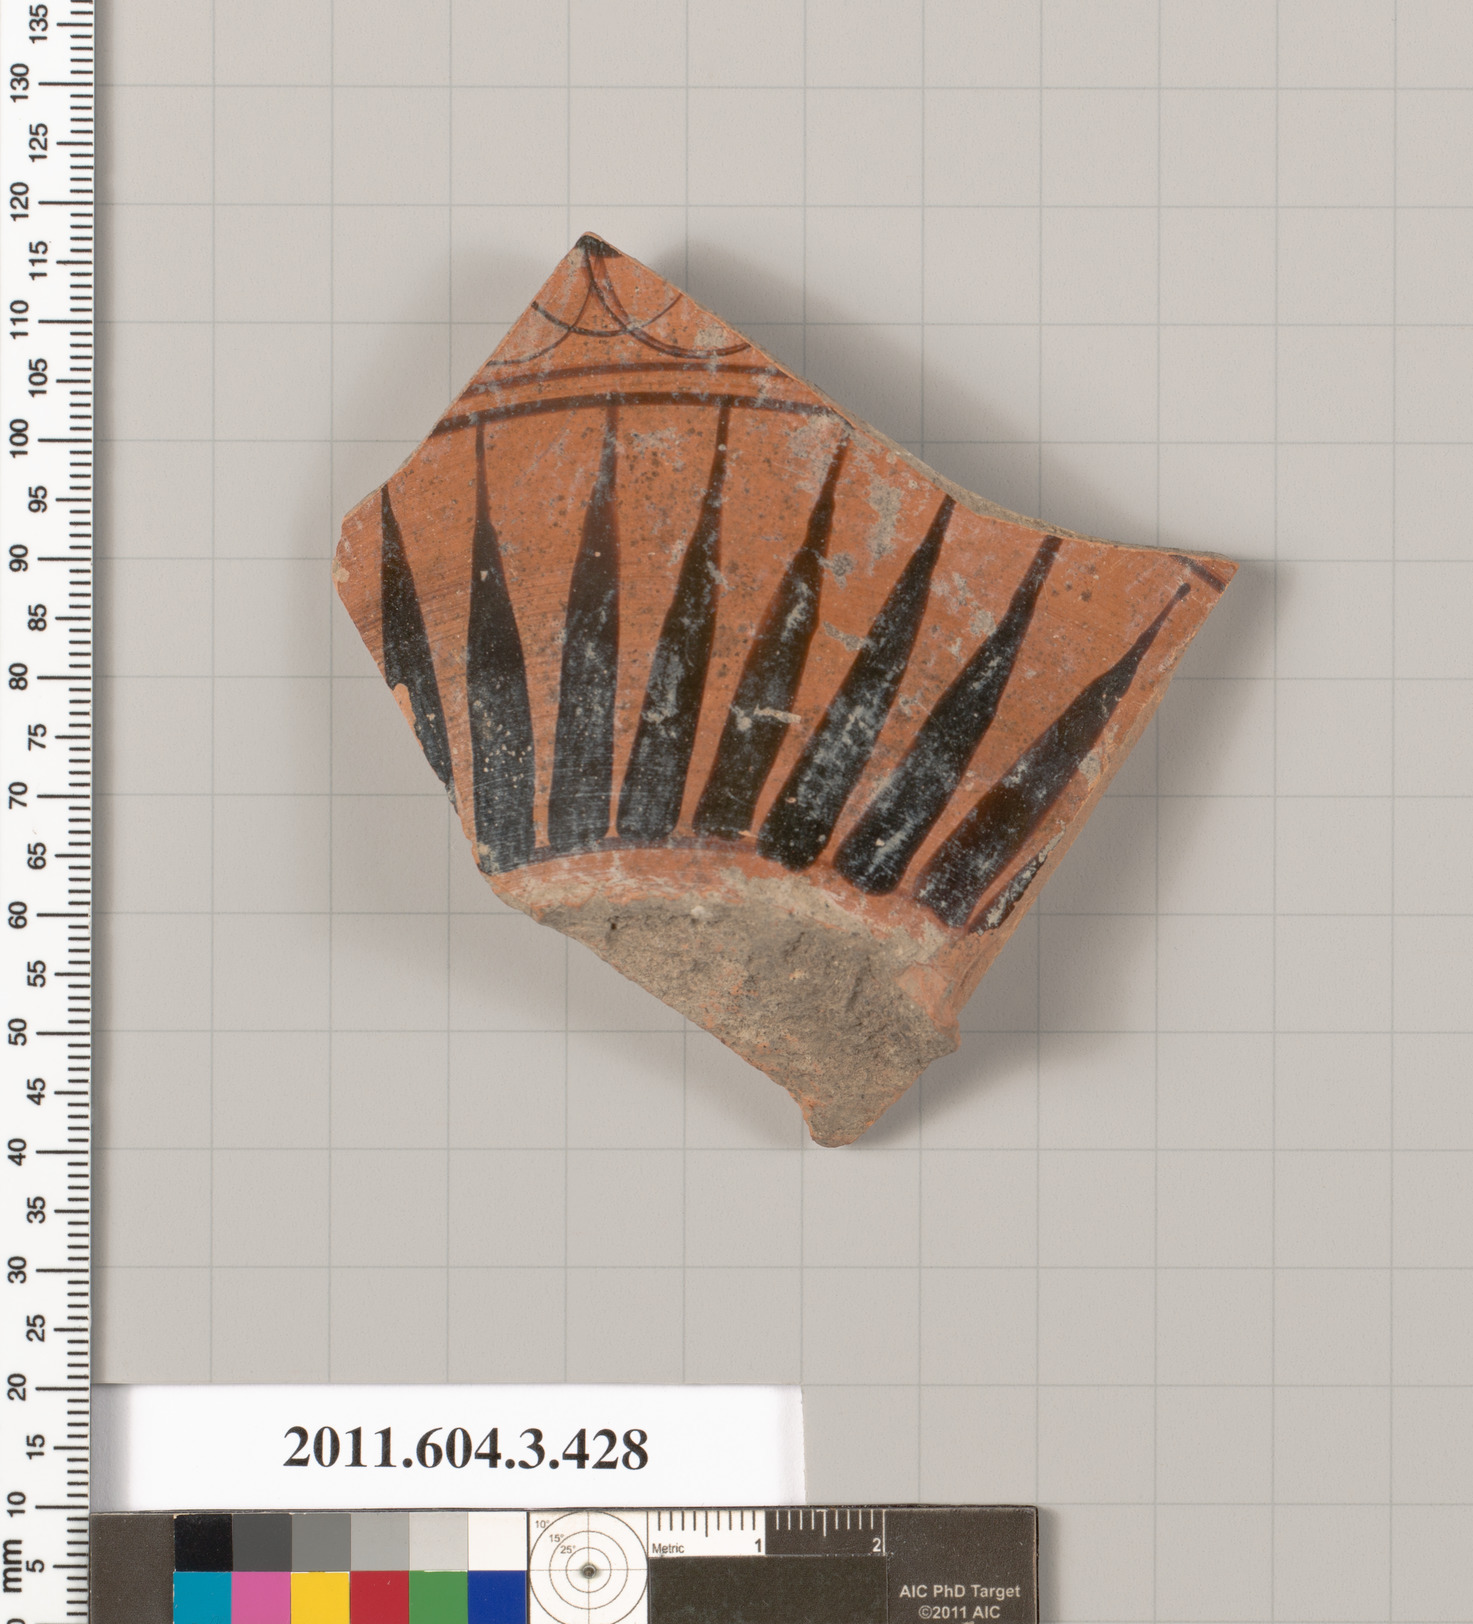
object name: neck amphora fragment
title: Terracotta fragment of a neck-amphora (jar)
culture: greek, attic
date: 520-510 BCE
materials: terracotta